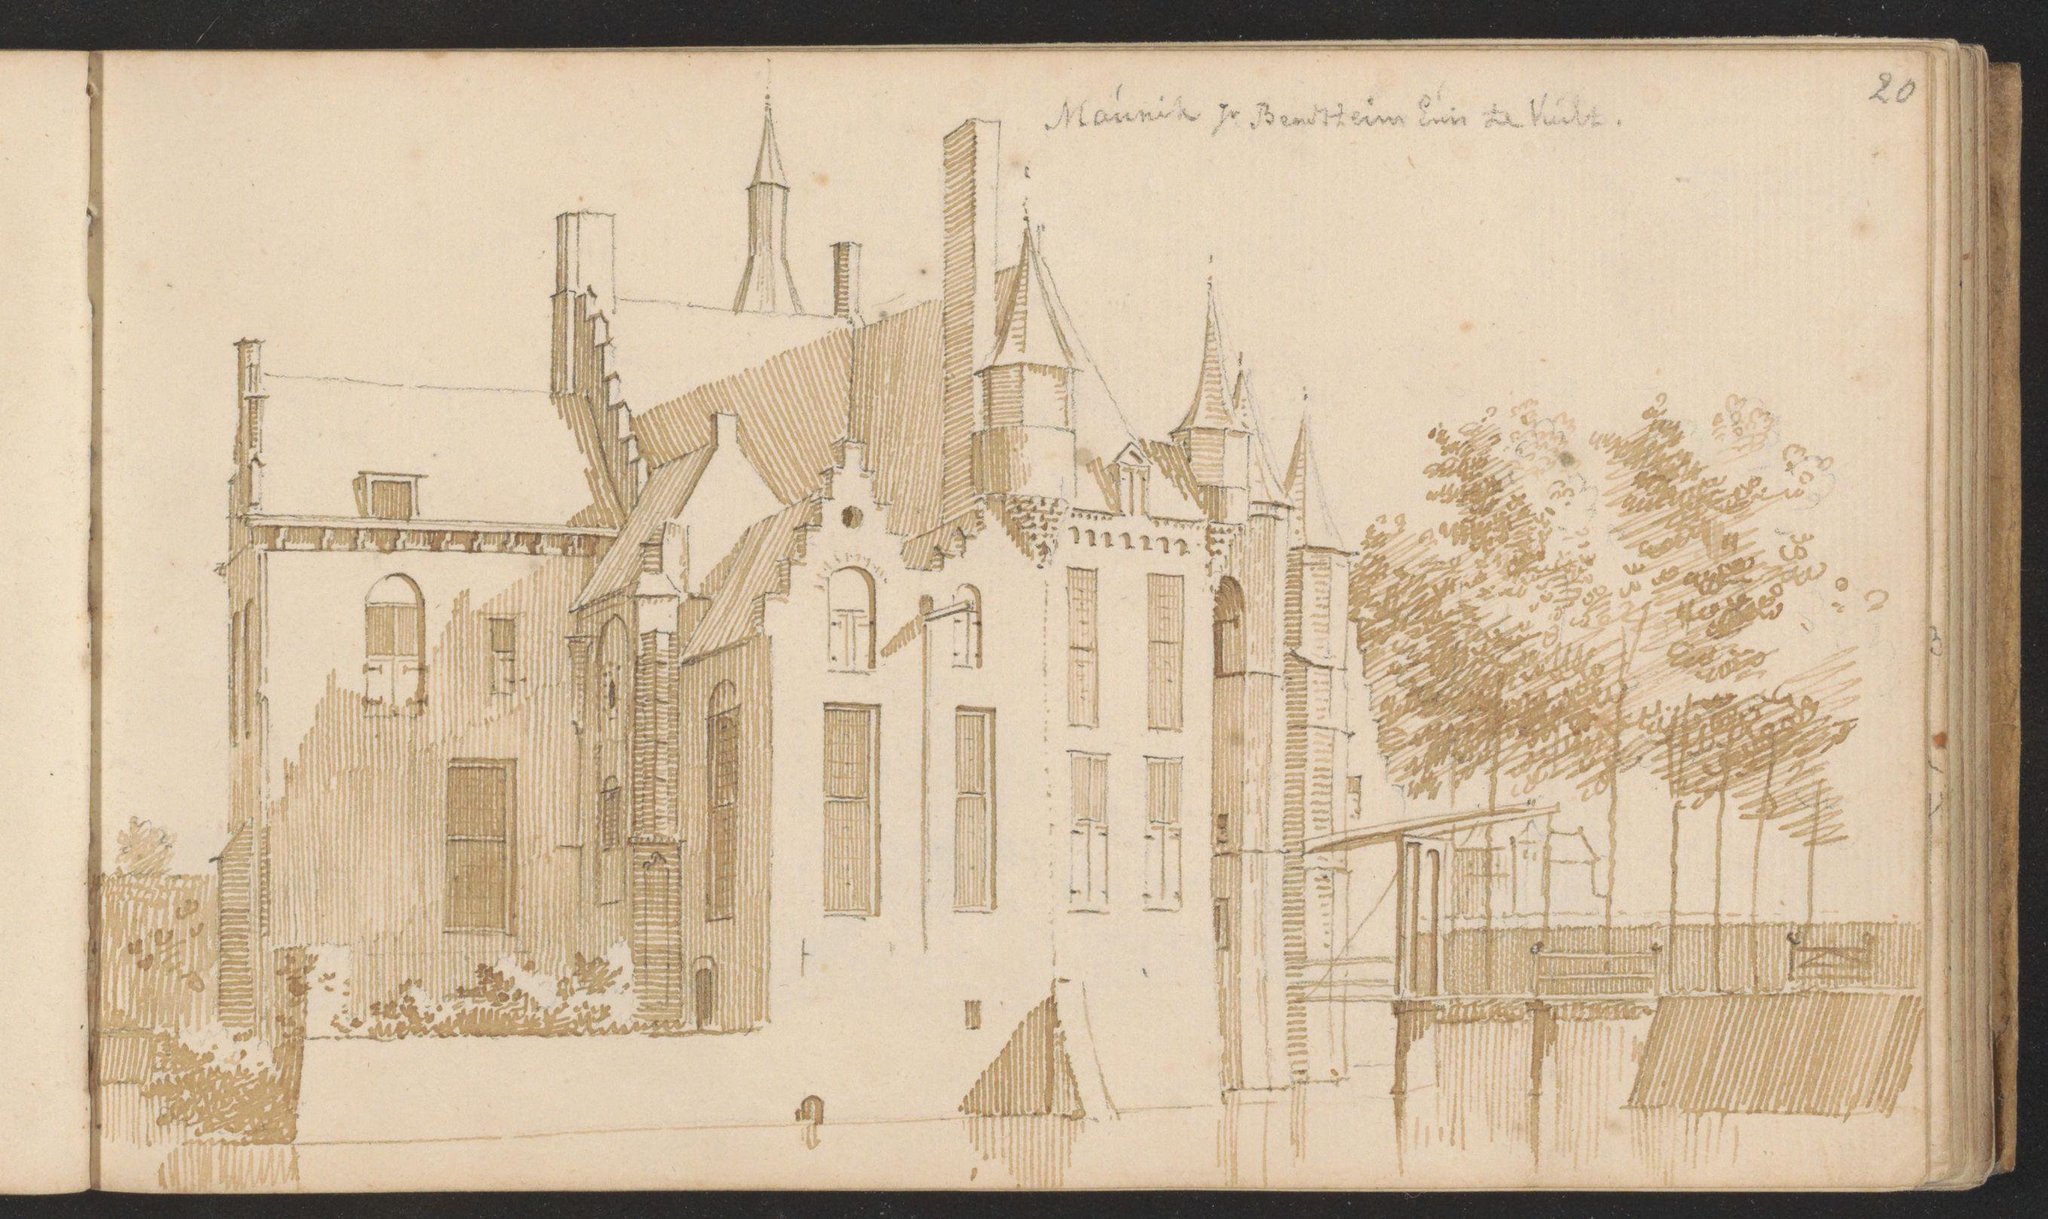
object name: sketchbook leaf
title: Kasteel Maurick te Vught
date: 1701-1759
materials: ink, paper, pencil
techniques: pen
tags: castle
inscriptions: annotation: ‘Maurik Jr Bentheim E[...] te Vucht’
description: Blad 20 recto uit een schetsboek met 65 bladen.